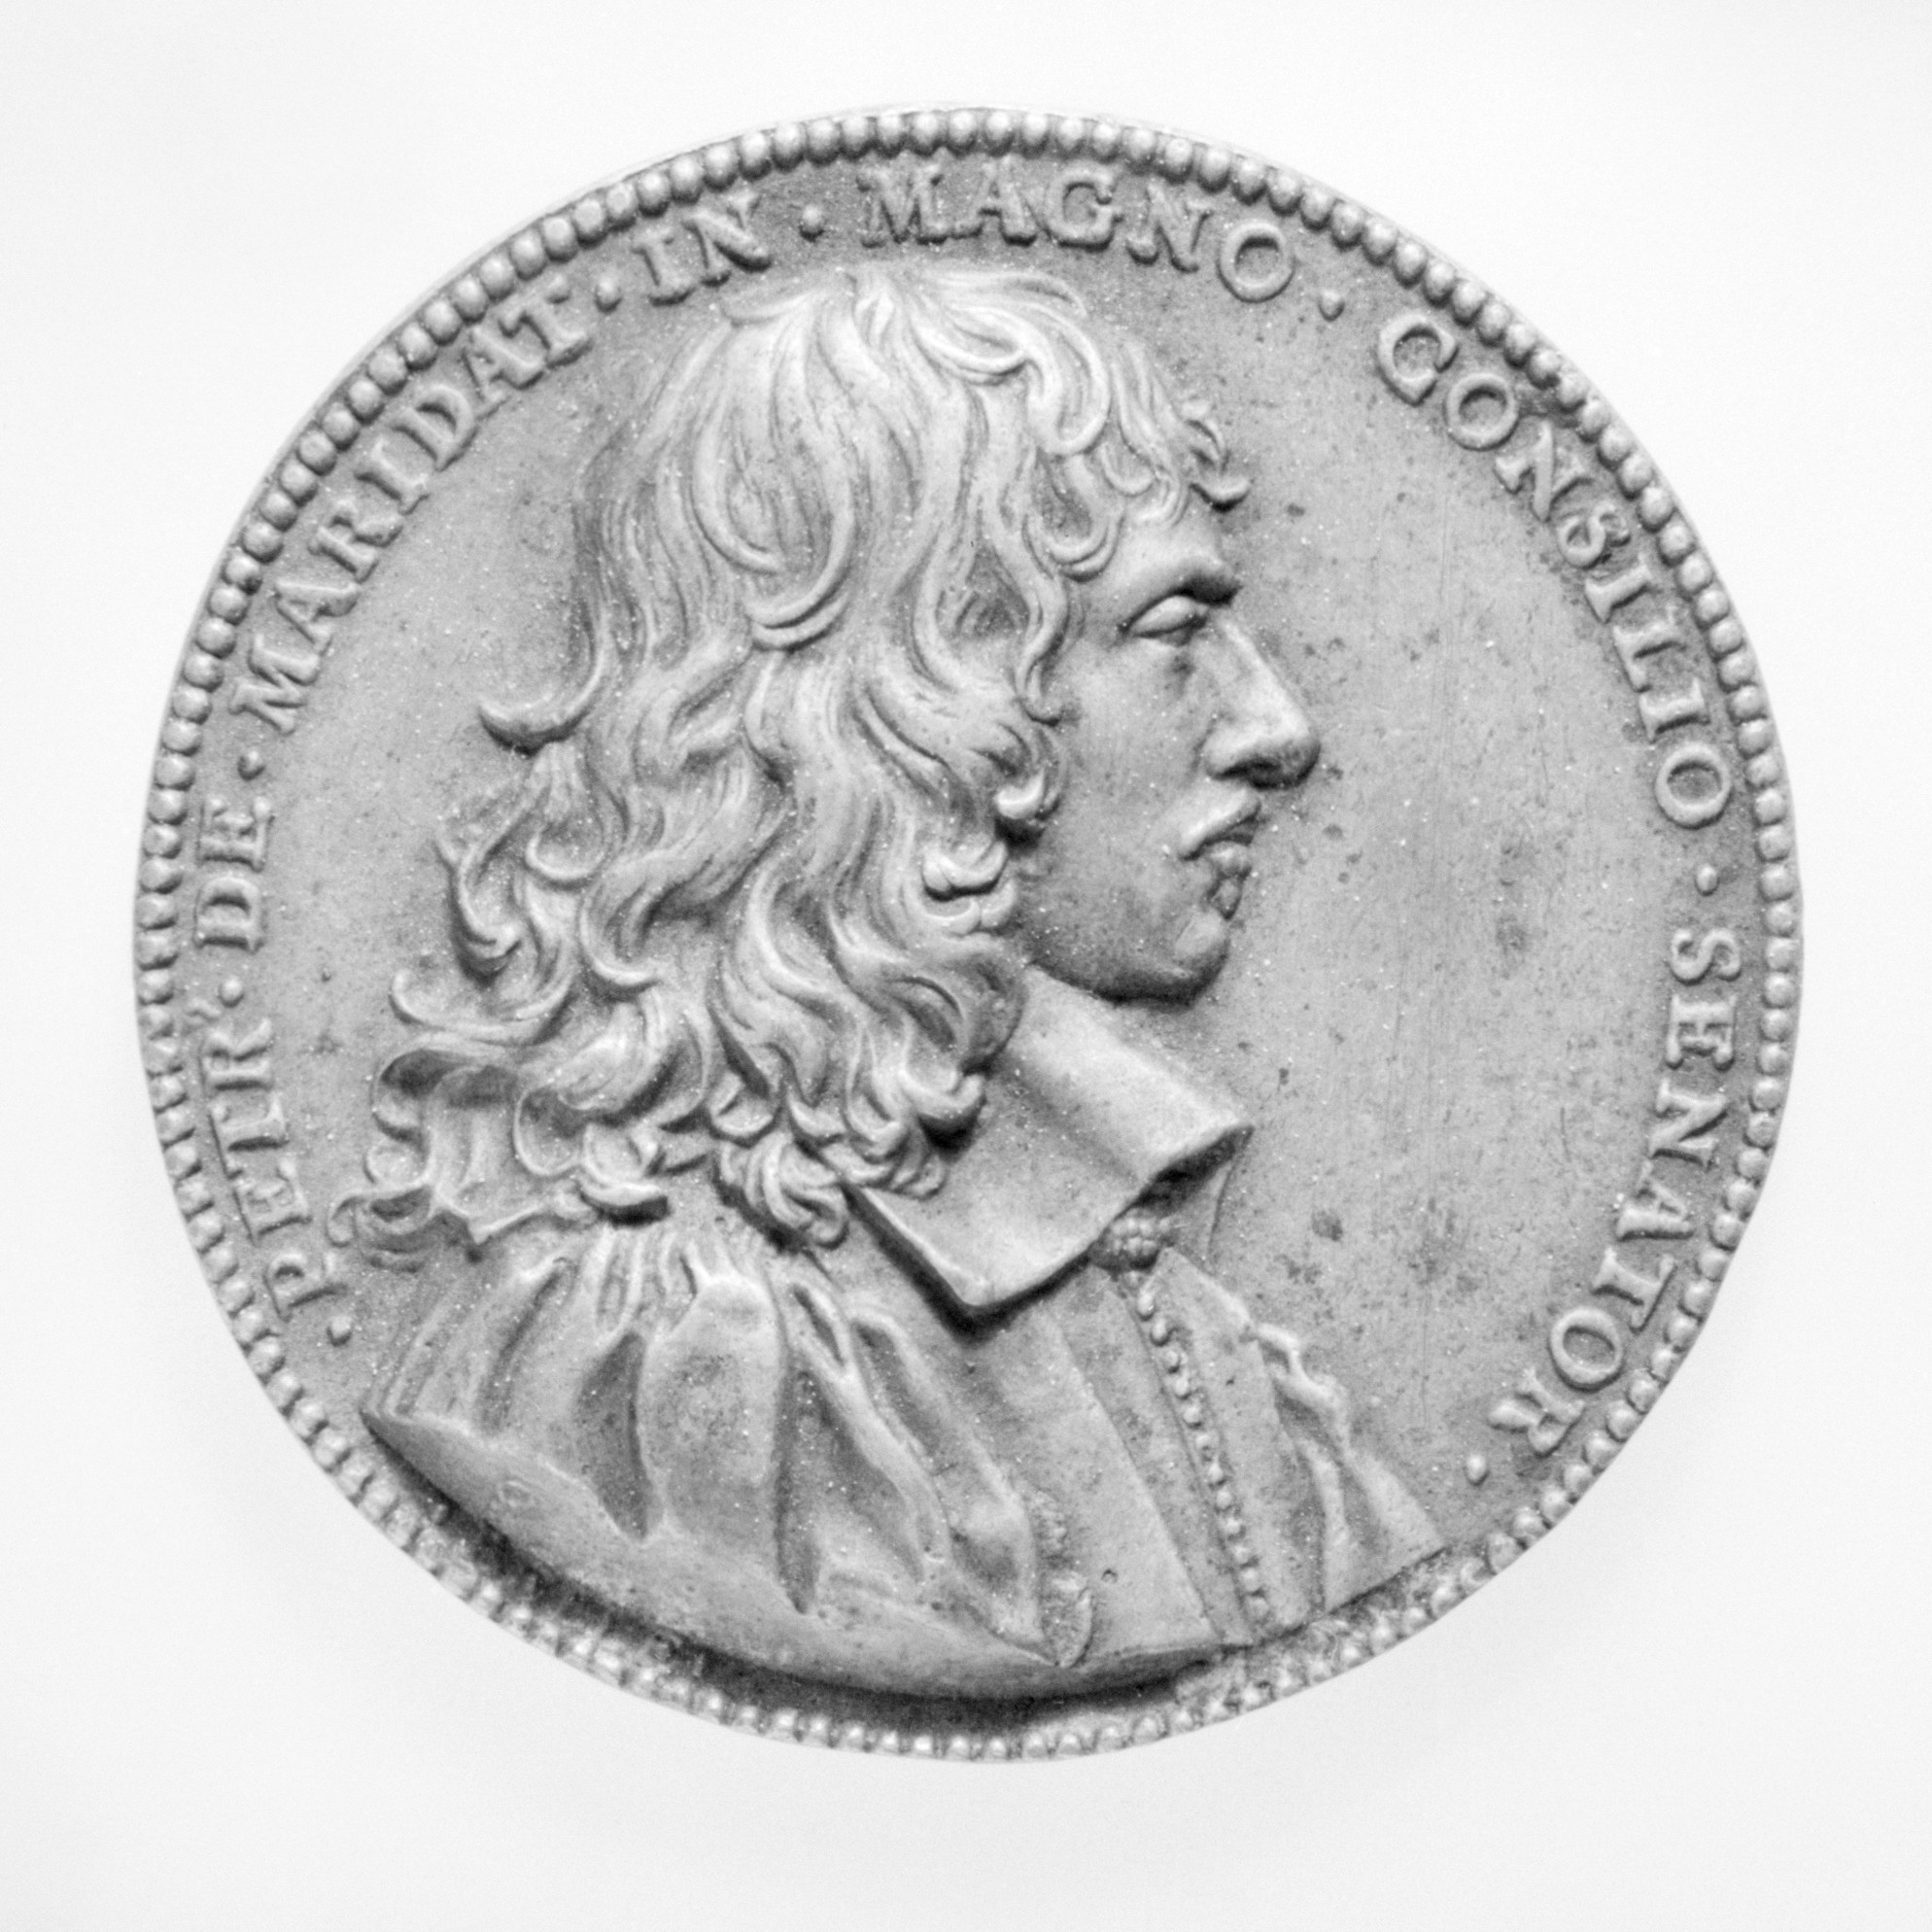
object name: medal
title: Pierre de Maridat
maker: i. josias belle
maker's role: artist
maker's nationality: french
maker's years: 1624-1695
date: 1656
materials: bronze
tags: men,profiles,coat of arms